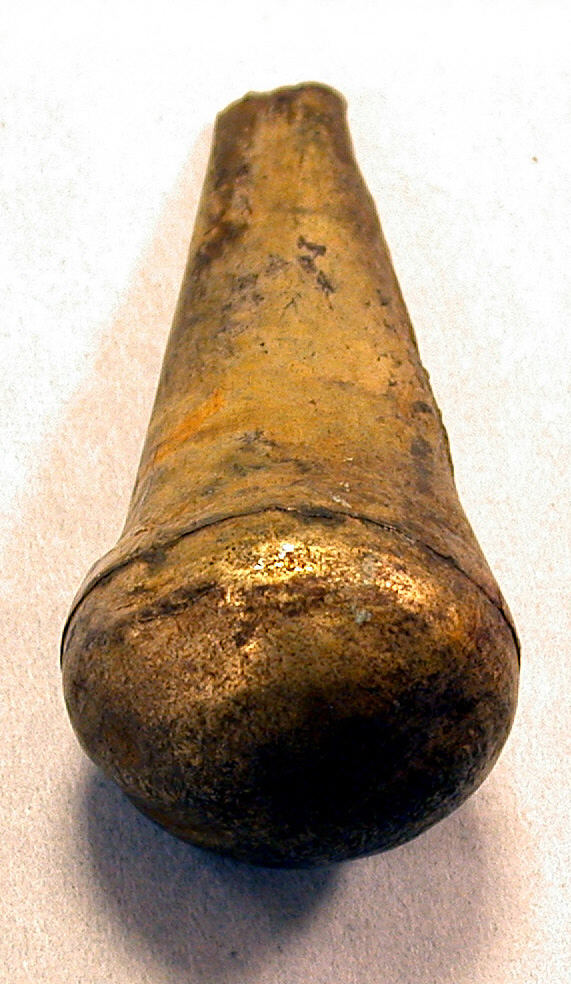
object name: ornament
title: Hammered Silver Cone Ornament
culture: peruvian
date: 701-1566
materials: gilt, silver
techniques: hammering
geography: peru